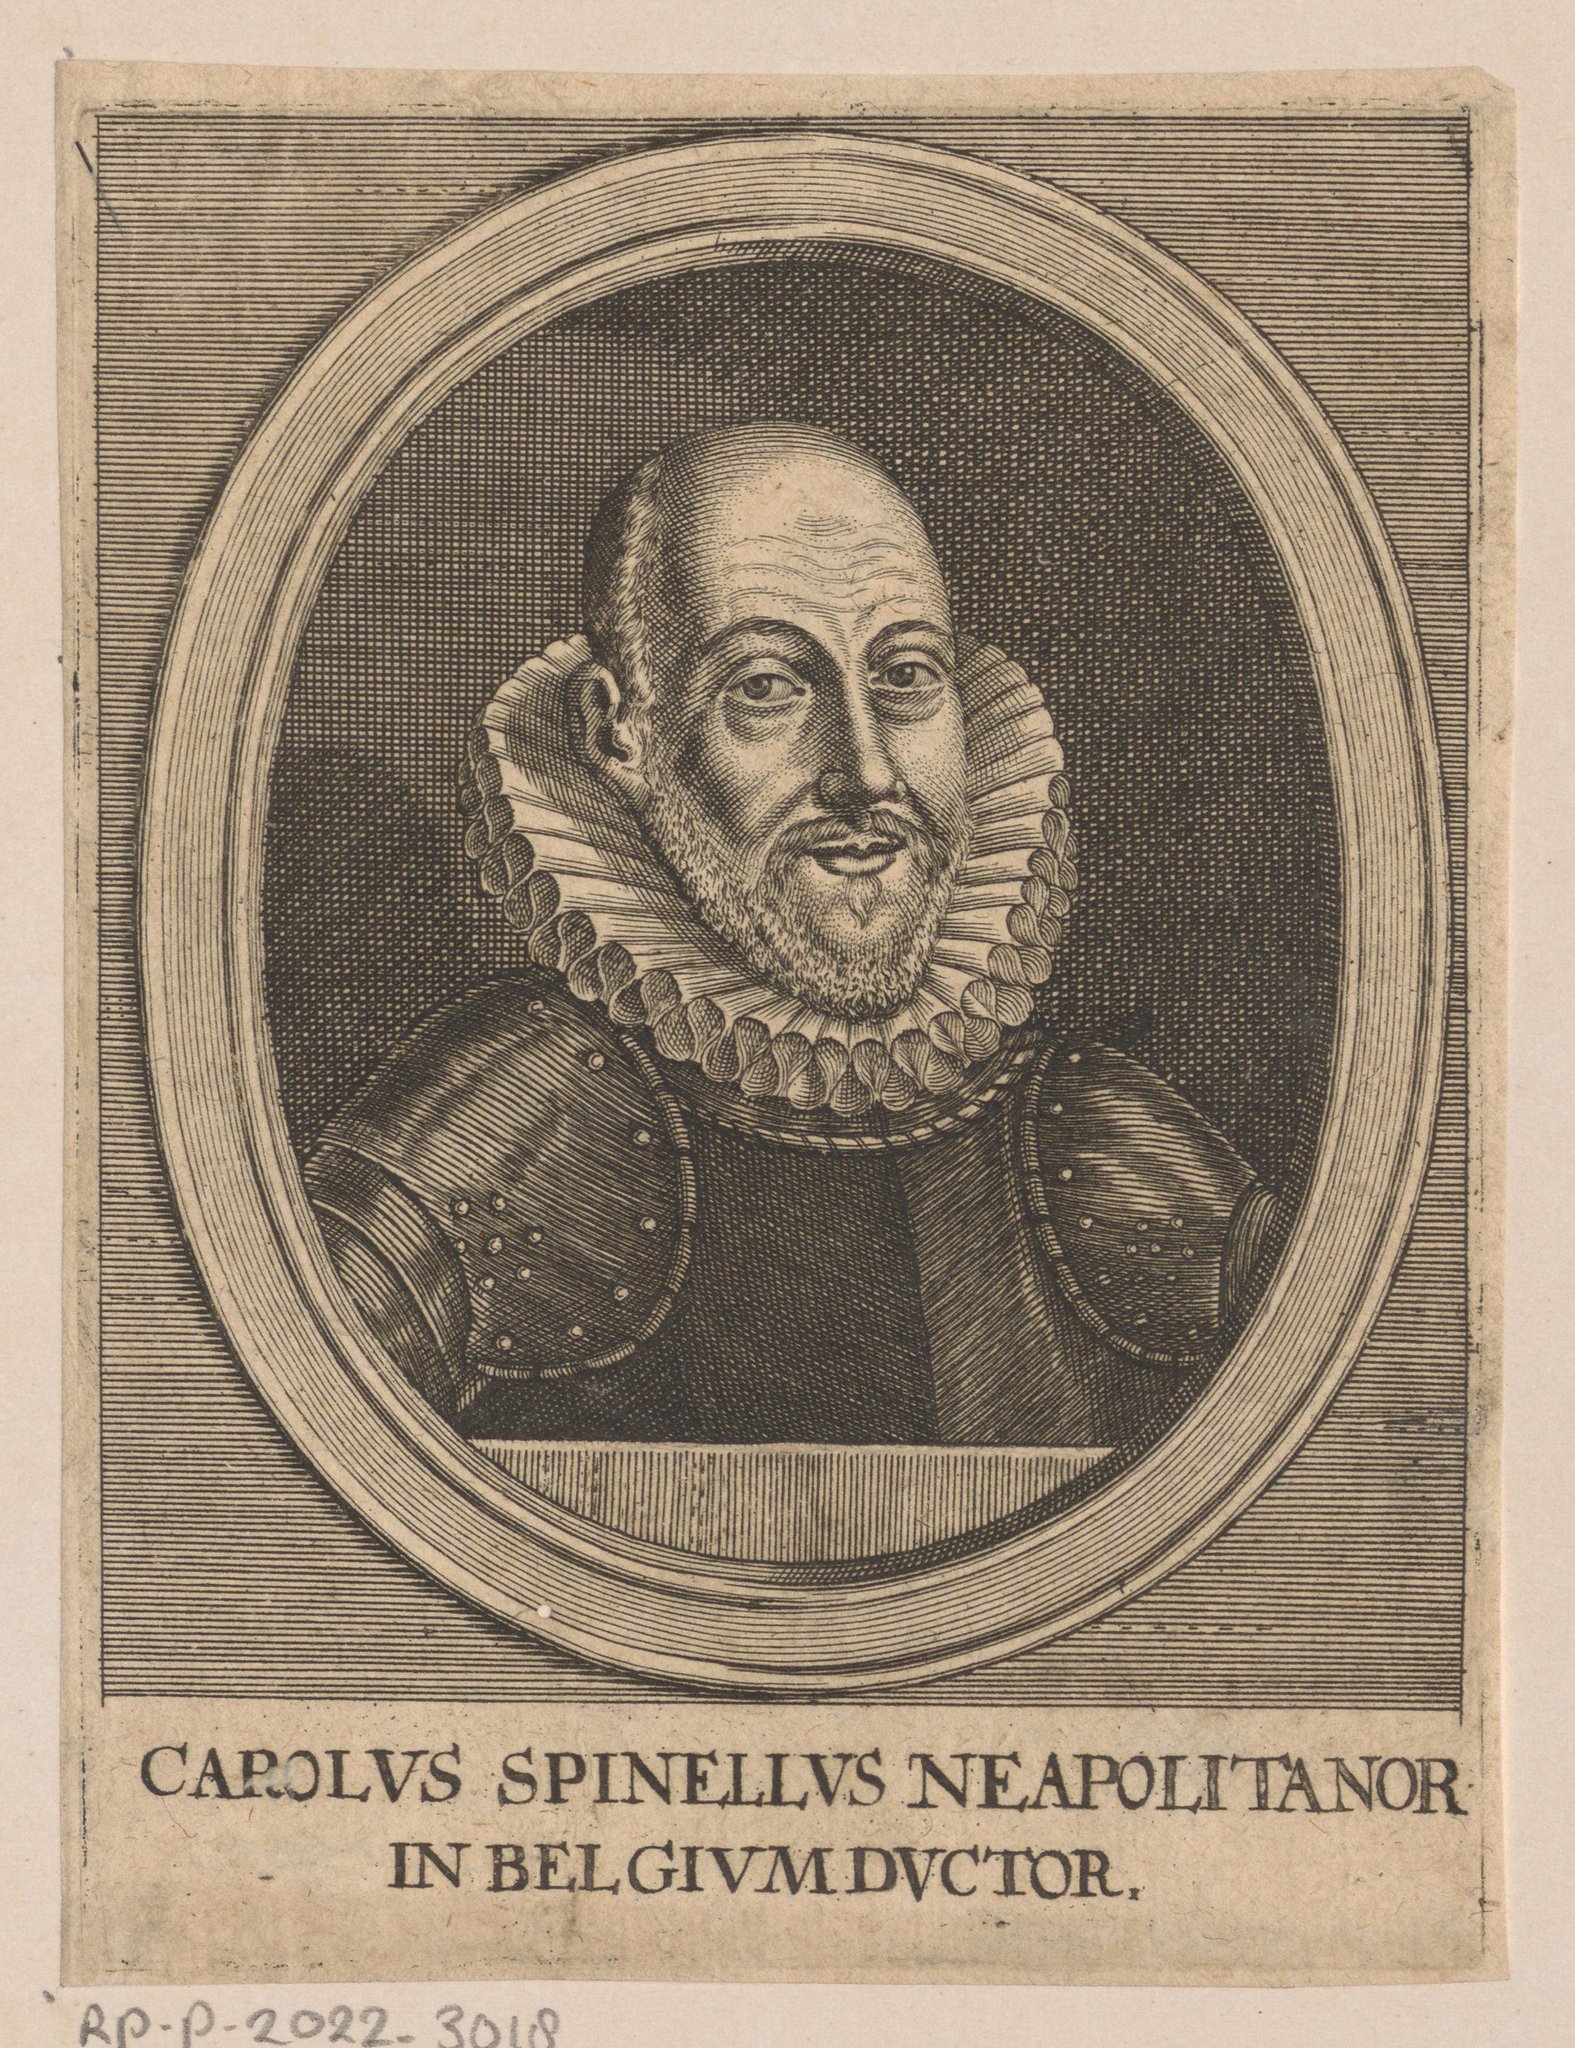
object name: print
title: Portret van Carlo Spinelli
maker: Anonymous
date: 1632-1750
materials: paper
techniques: engraving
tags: commander-in-chief, general, marshal, historical persons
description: Prent mogelijk uit een van de delen en/of vertalingen van: Strada, Famiano. De bello Belgico. Uitgegeven tussen 1632-1750.